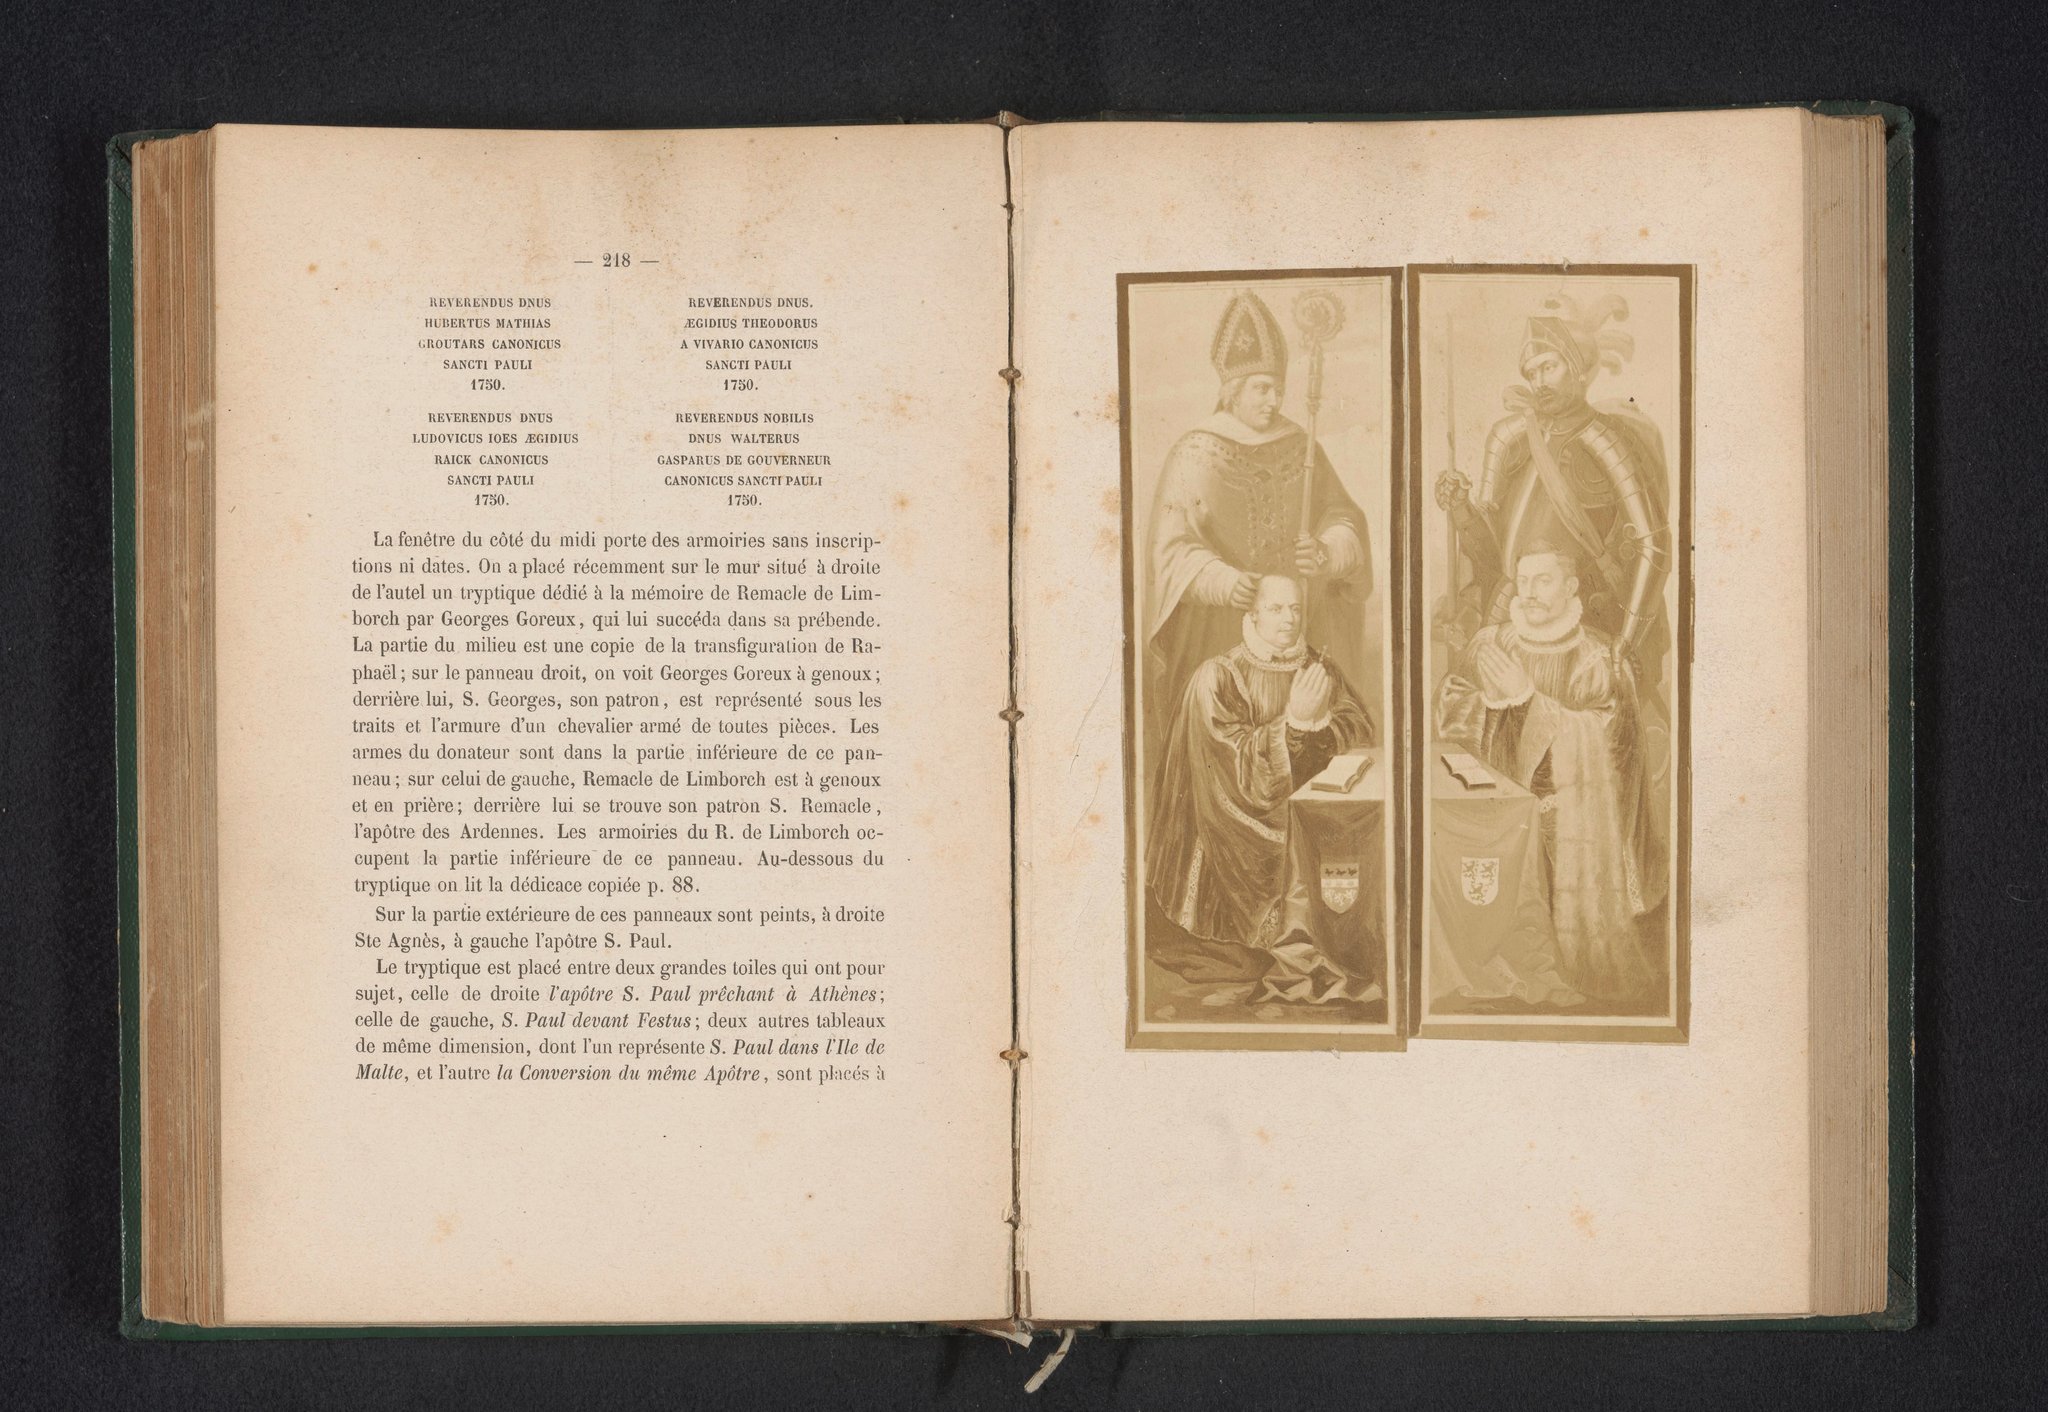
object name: page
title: Fotoreproductie van een ontwerp van een biddende man, met achter hem een bisschop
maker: Anonymous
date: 1862-1867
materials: photographic support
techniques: albumen print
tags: archbishop, bishop, etc. (roman catholic), one person praying